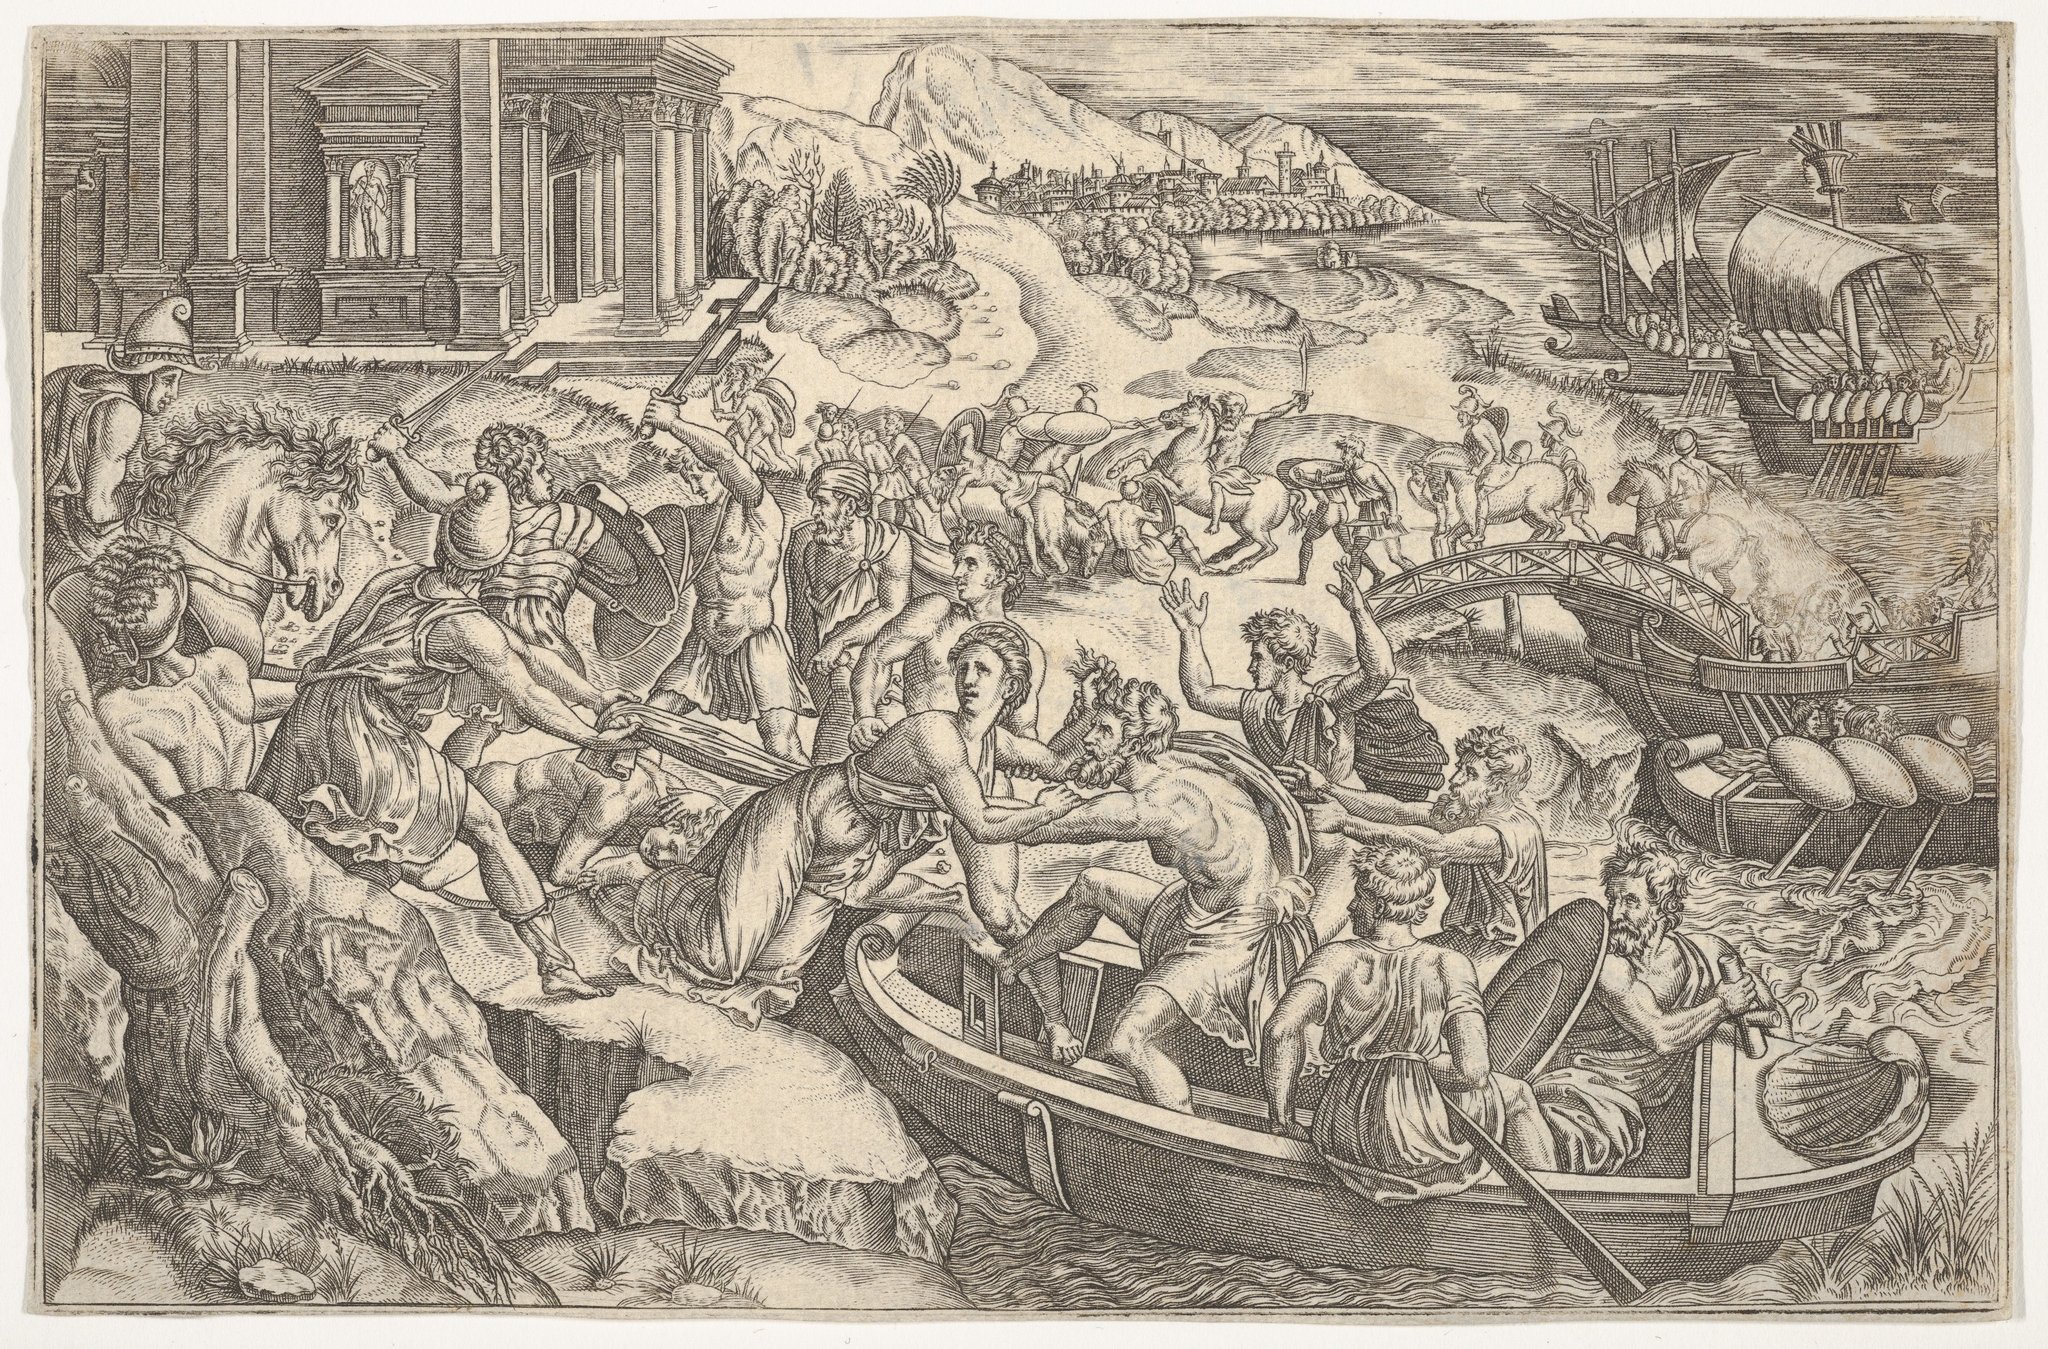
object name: print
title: Tha Abduction of Helen (L'Enlèvement d'Hélène)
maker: etienne delaune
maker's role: artist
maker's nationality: french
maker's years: 1518-1583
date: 1540-1583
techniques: etching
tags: battles,soldiers,helen,boats